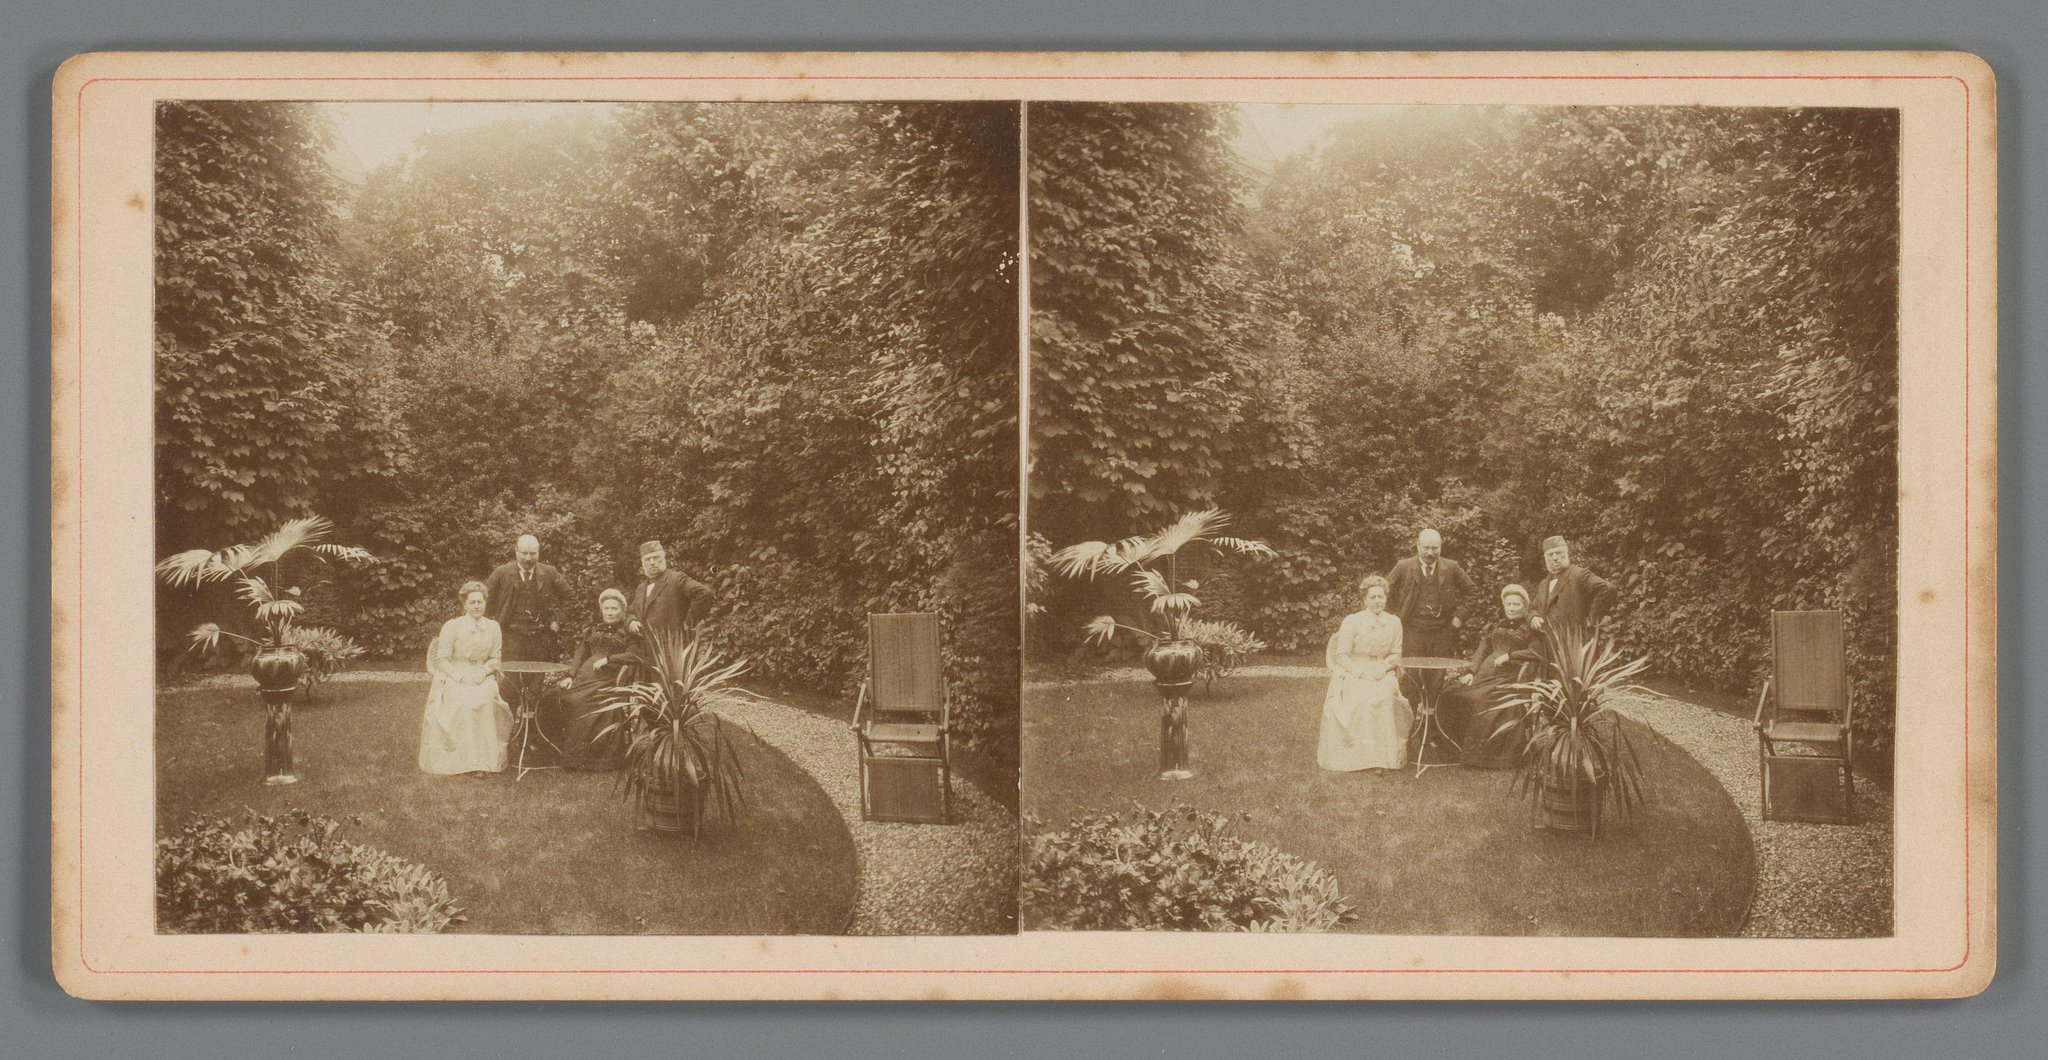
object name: stereograph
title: Portret van Hendrina (Dina) de Jong-Ploeg, Piet de Jong, Johanna de Jong-Voet en Lambertus de Jong in de tuin van Piet de Jong in Arnhem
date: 1900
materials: cardboard, photographic support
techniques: collodion silver print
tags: lambertus de jong, johanna petronella de jong-voet, hendrina johanna de jong-ploeg (dina), haarlem, arnhem, piet de jong (fotograaf), garden, historical persons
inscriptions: address: ‘Velperplein 14 Arnhem’, inscription: ‘Dina/Ploeg/ Piet/ Johanna/Voet/ Lambertus’